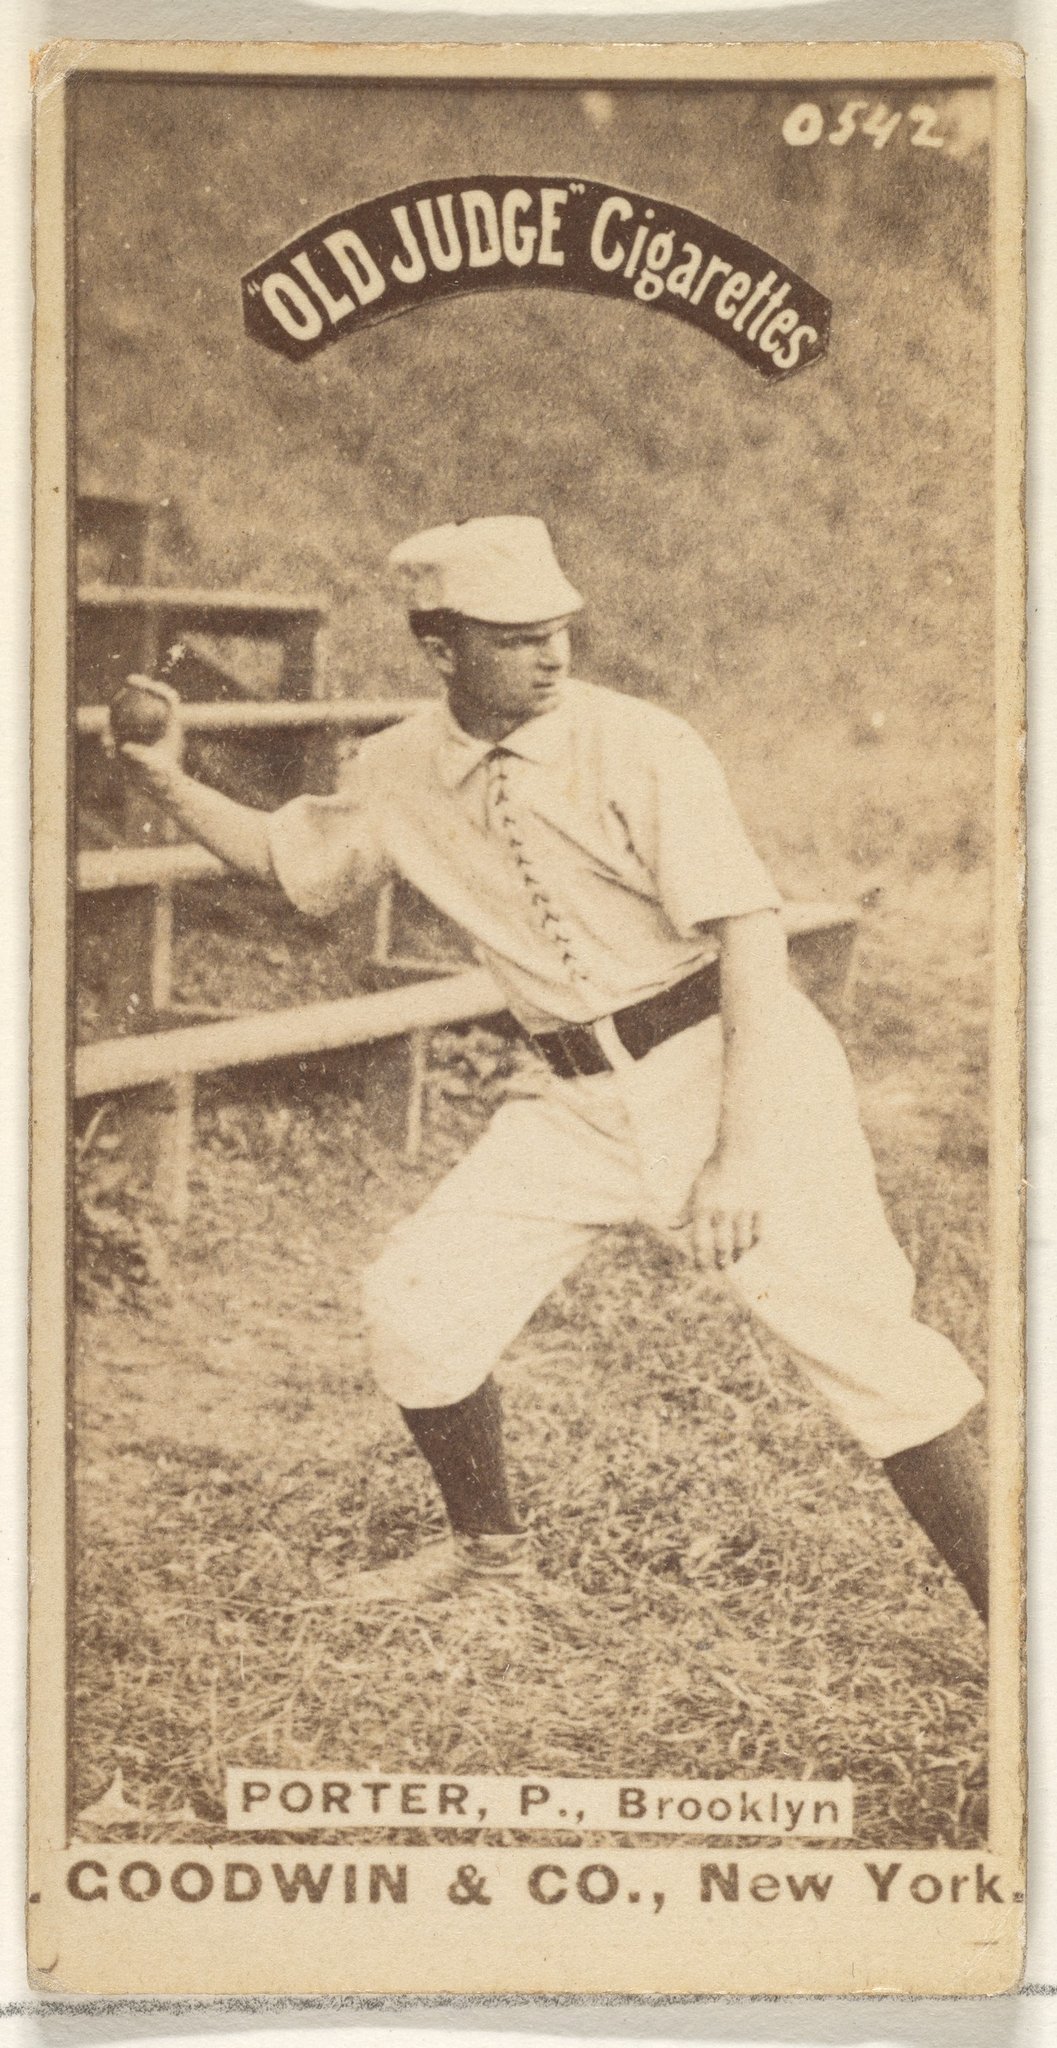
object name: baseball card, photograph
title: Porter, Pitcher, Brooklyn, from the Old Judge series (N172) for Old Judge Cigarettes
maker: goodwin & company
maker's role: publisher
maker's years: 1850-1950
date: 1887-1890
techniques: albumen silver print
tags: men,portraits,baseball,athletes